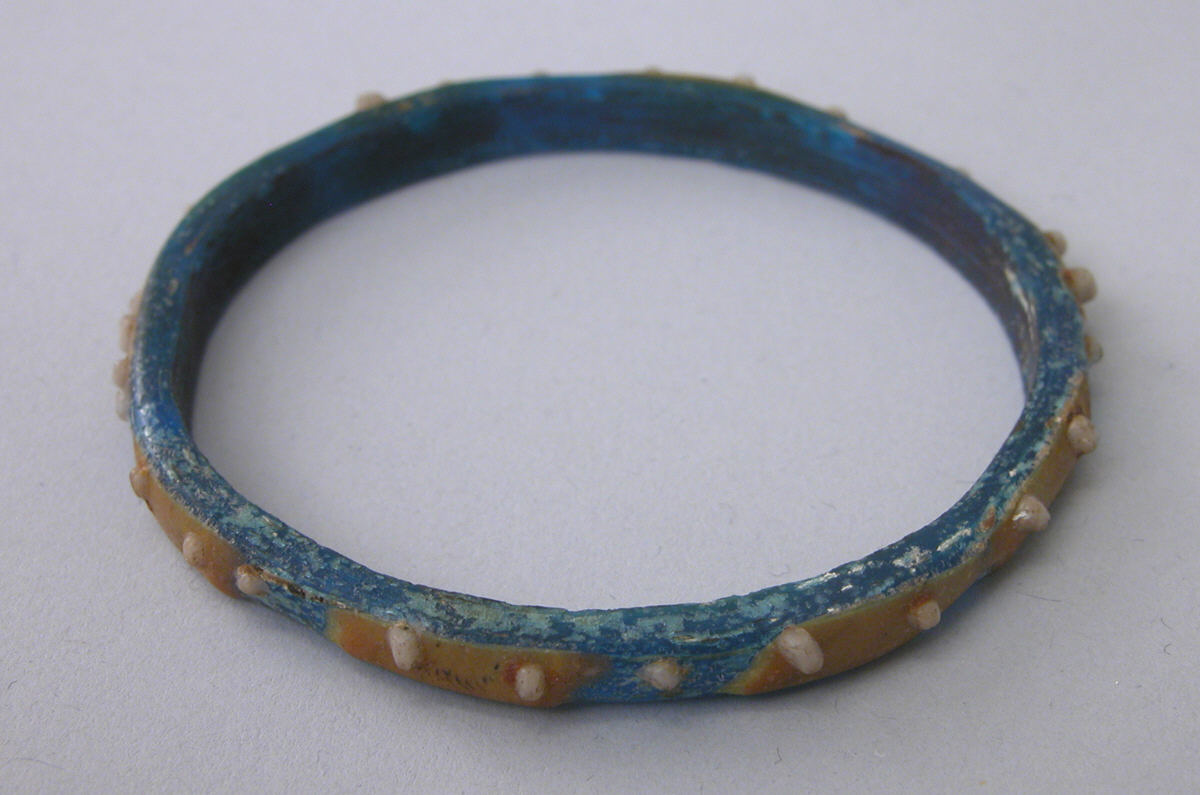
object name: bracelet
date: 1301-1500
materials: glass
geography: egypt or syria